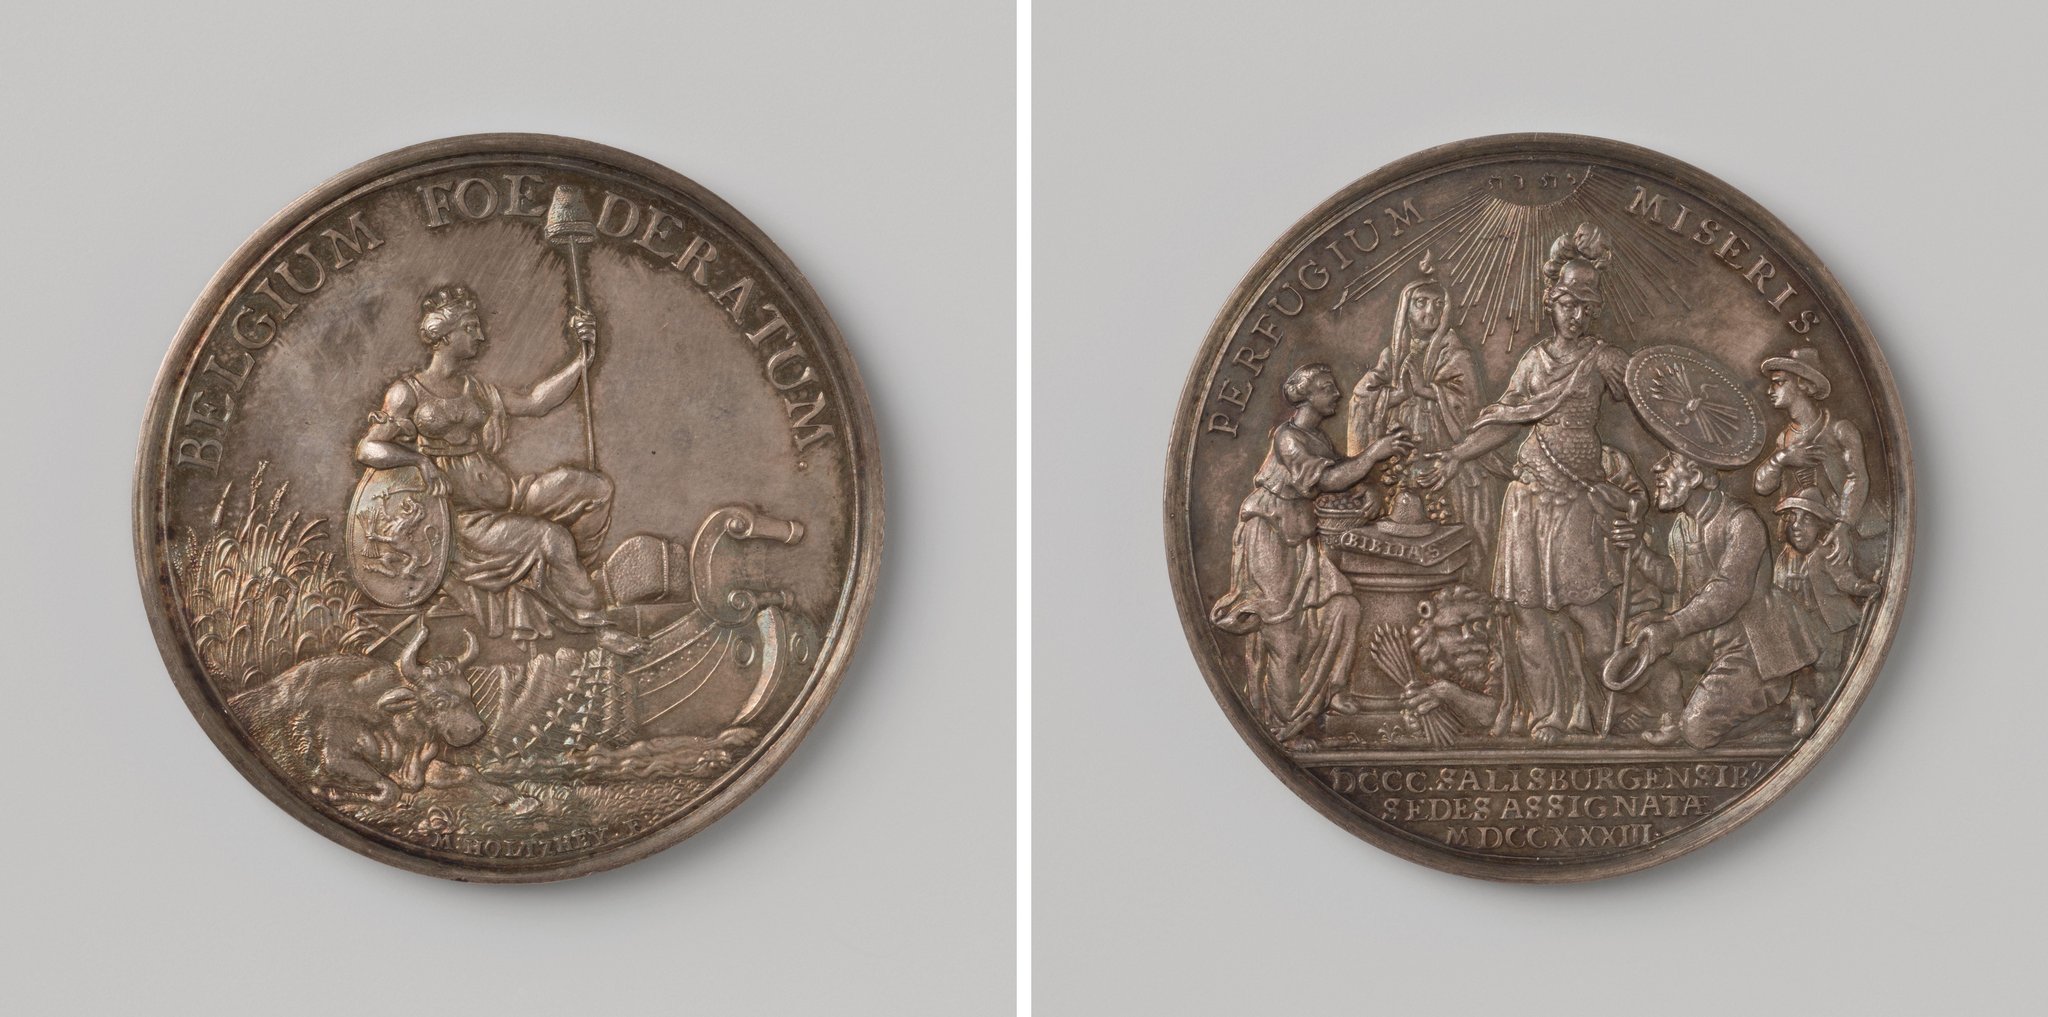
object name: history medal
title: Opname der Salzburger emigranten in de Republiek der Verenigde Nederlanden.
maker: martinus holtzhey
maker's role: medailleur, muntmaker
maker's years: 1697-1764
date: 1733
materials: silver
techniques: striking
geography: amsterdam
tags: breskens, opname der salzburger emigranten in nederland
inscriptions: caption: ‘DCCC. SALISBURGENSIB./ SEDES ASSIGNATÆ/ MDCCXXXIII.’, circumscription: ‘REFUGIUM MISERIS’, circumscription: ‘BELGIUM FOEDERATUM’